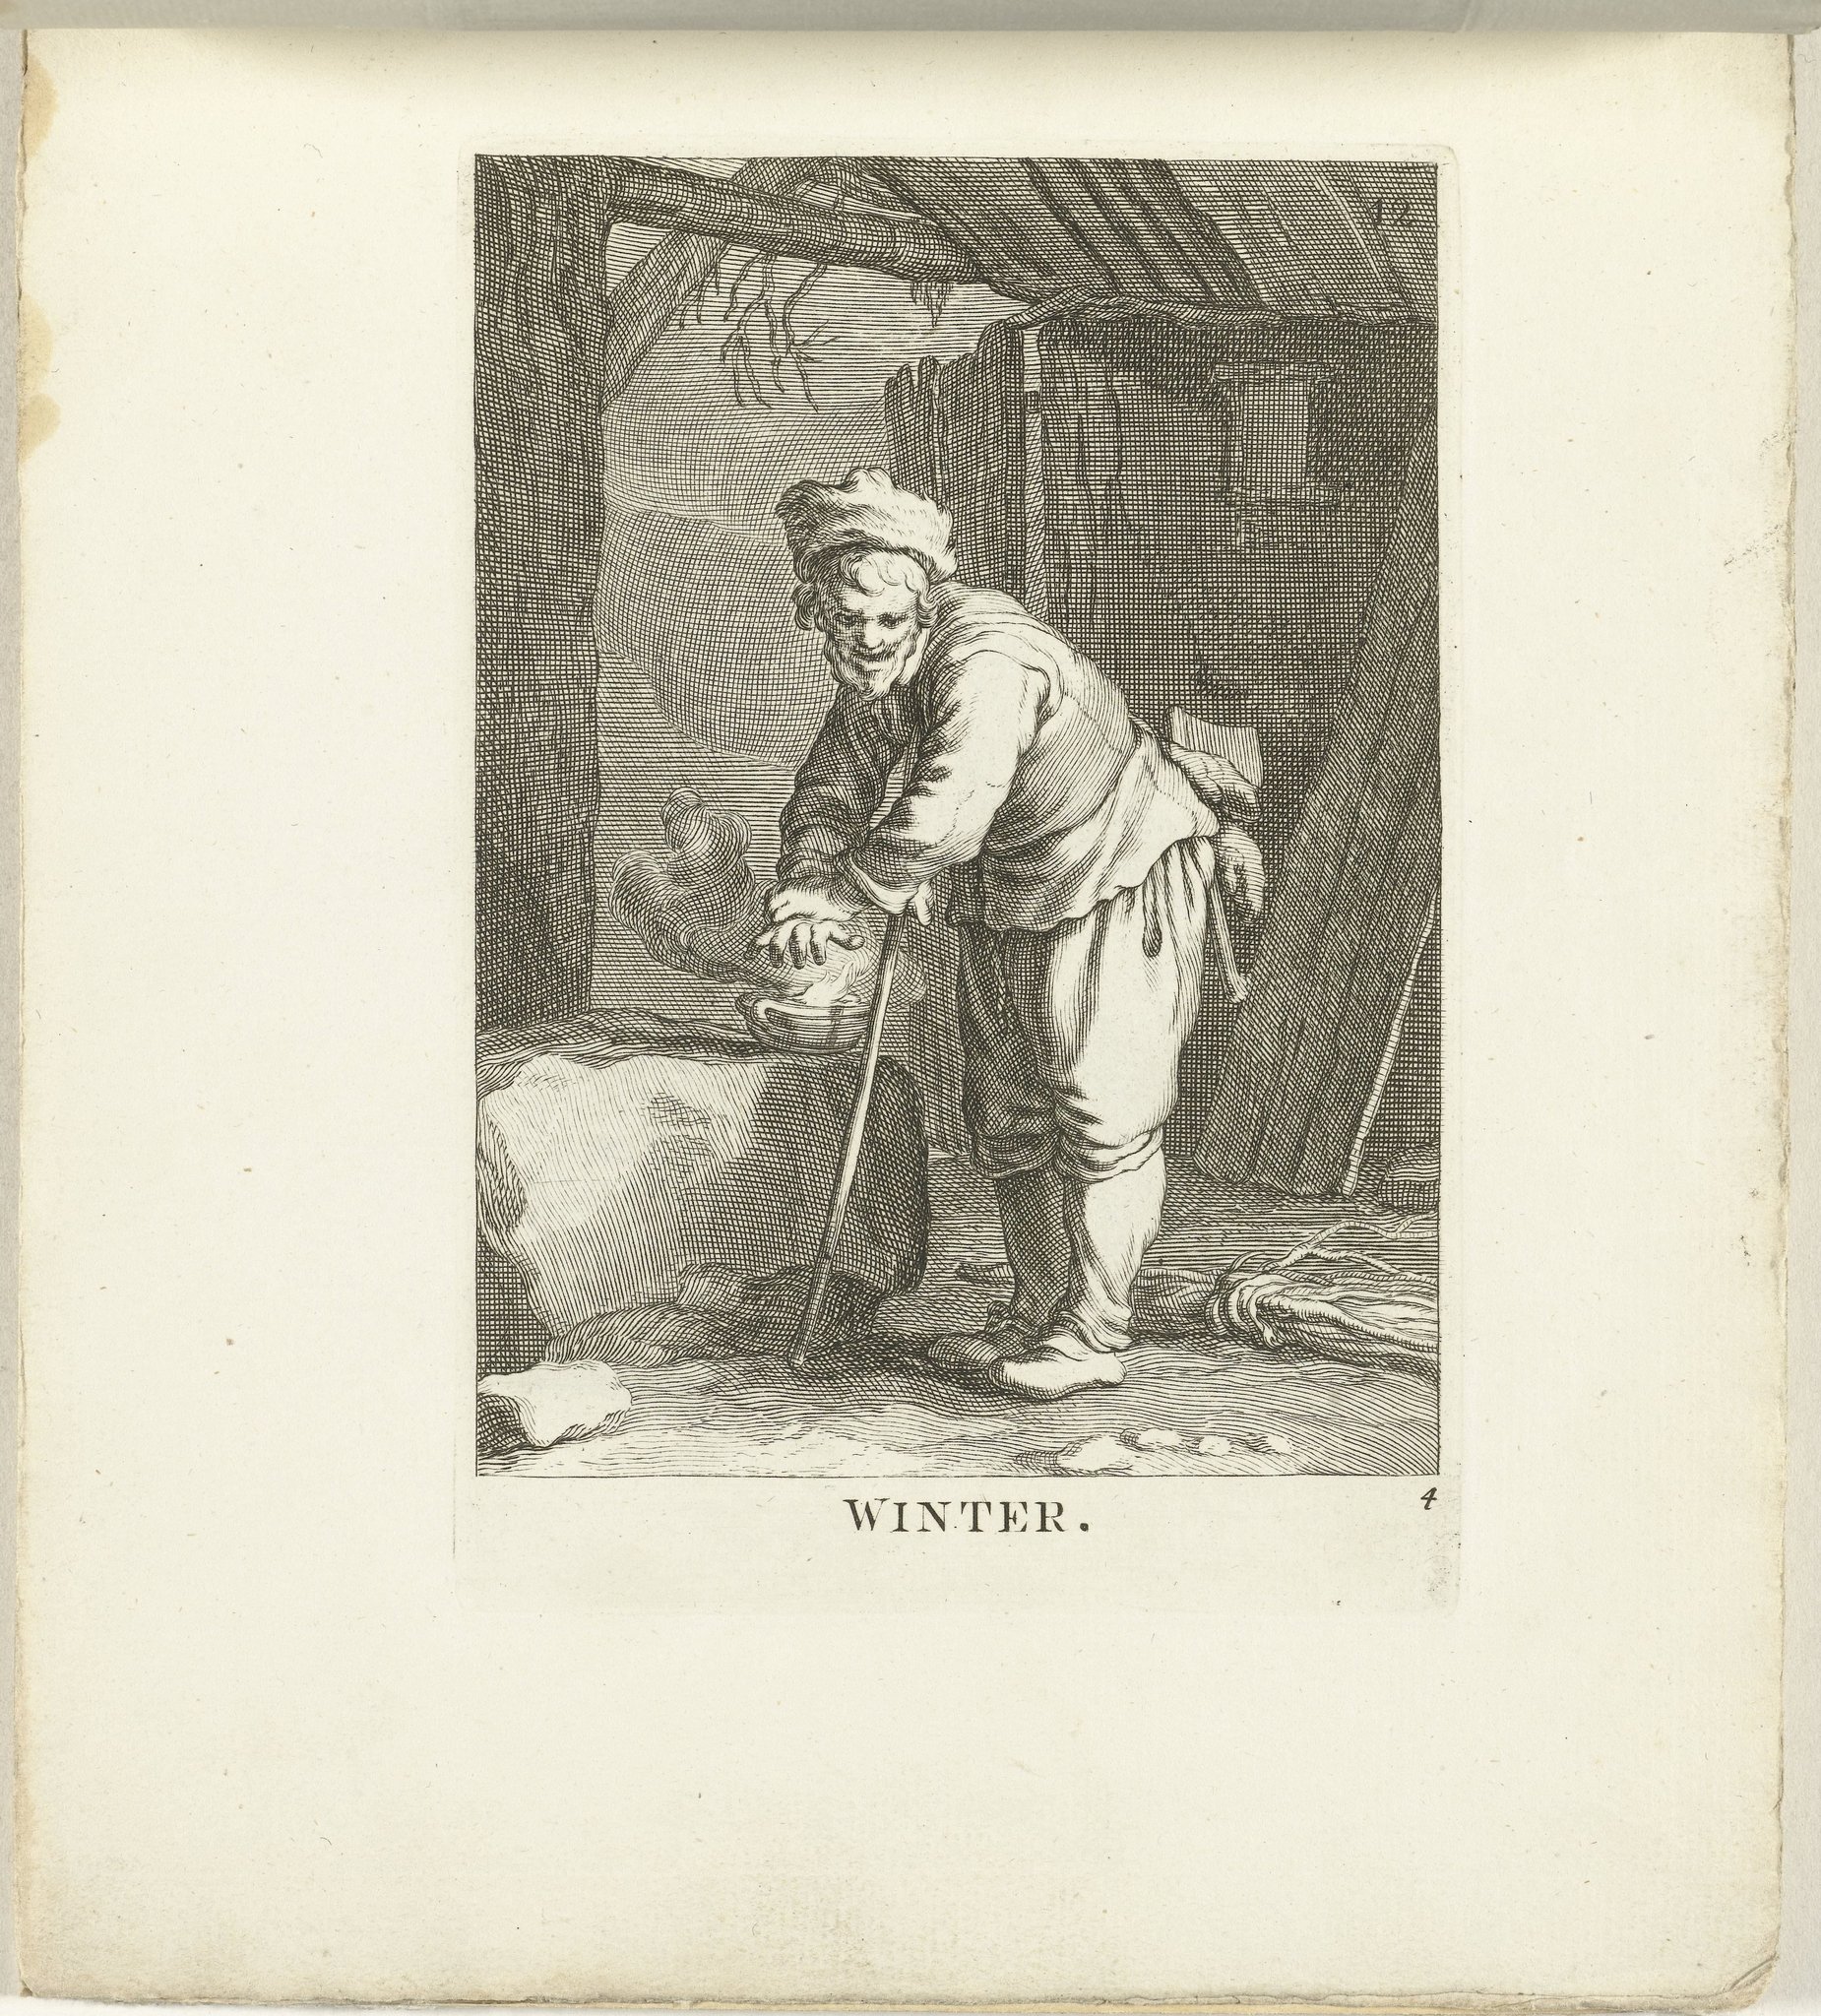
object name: print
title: Winter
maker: frederick bloemaert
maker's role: print maker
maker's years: 1614-1669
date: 1700-1800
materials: paper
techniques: engraving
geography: utrecht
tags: winter, 'hyems'; 'inverno' (ripa), warming oneself at a fire (or hearth, stove, fire-pan, brazier), seasons of the year (esp. personifications); 'stagione', 'le quattro stagione dell'anno' (ripa) (+ with scenes showing human occupations ~ seasons and months)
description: Een oude man warmt zijn handen aan een vuurtje. Oorspronkelijk prent 4 uit een serie met de vier seizoenen naar Abraham Bloemaert. In deze gemengde serie prent 12.